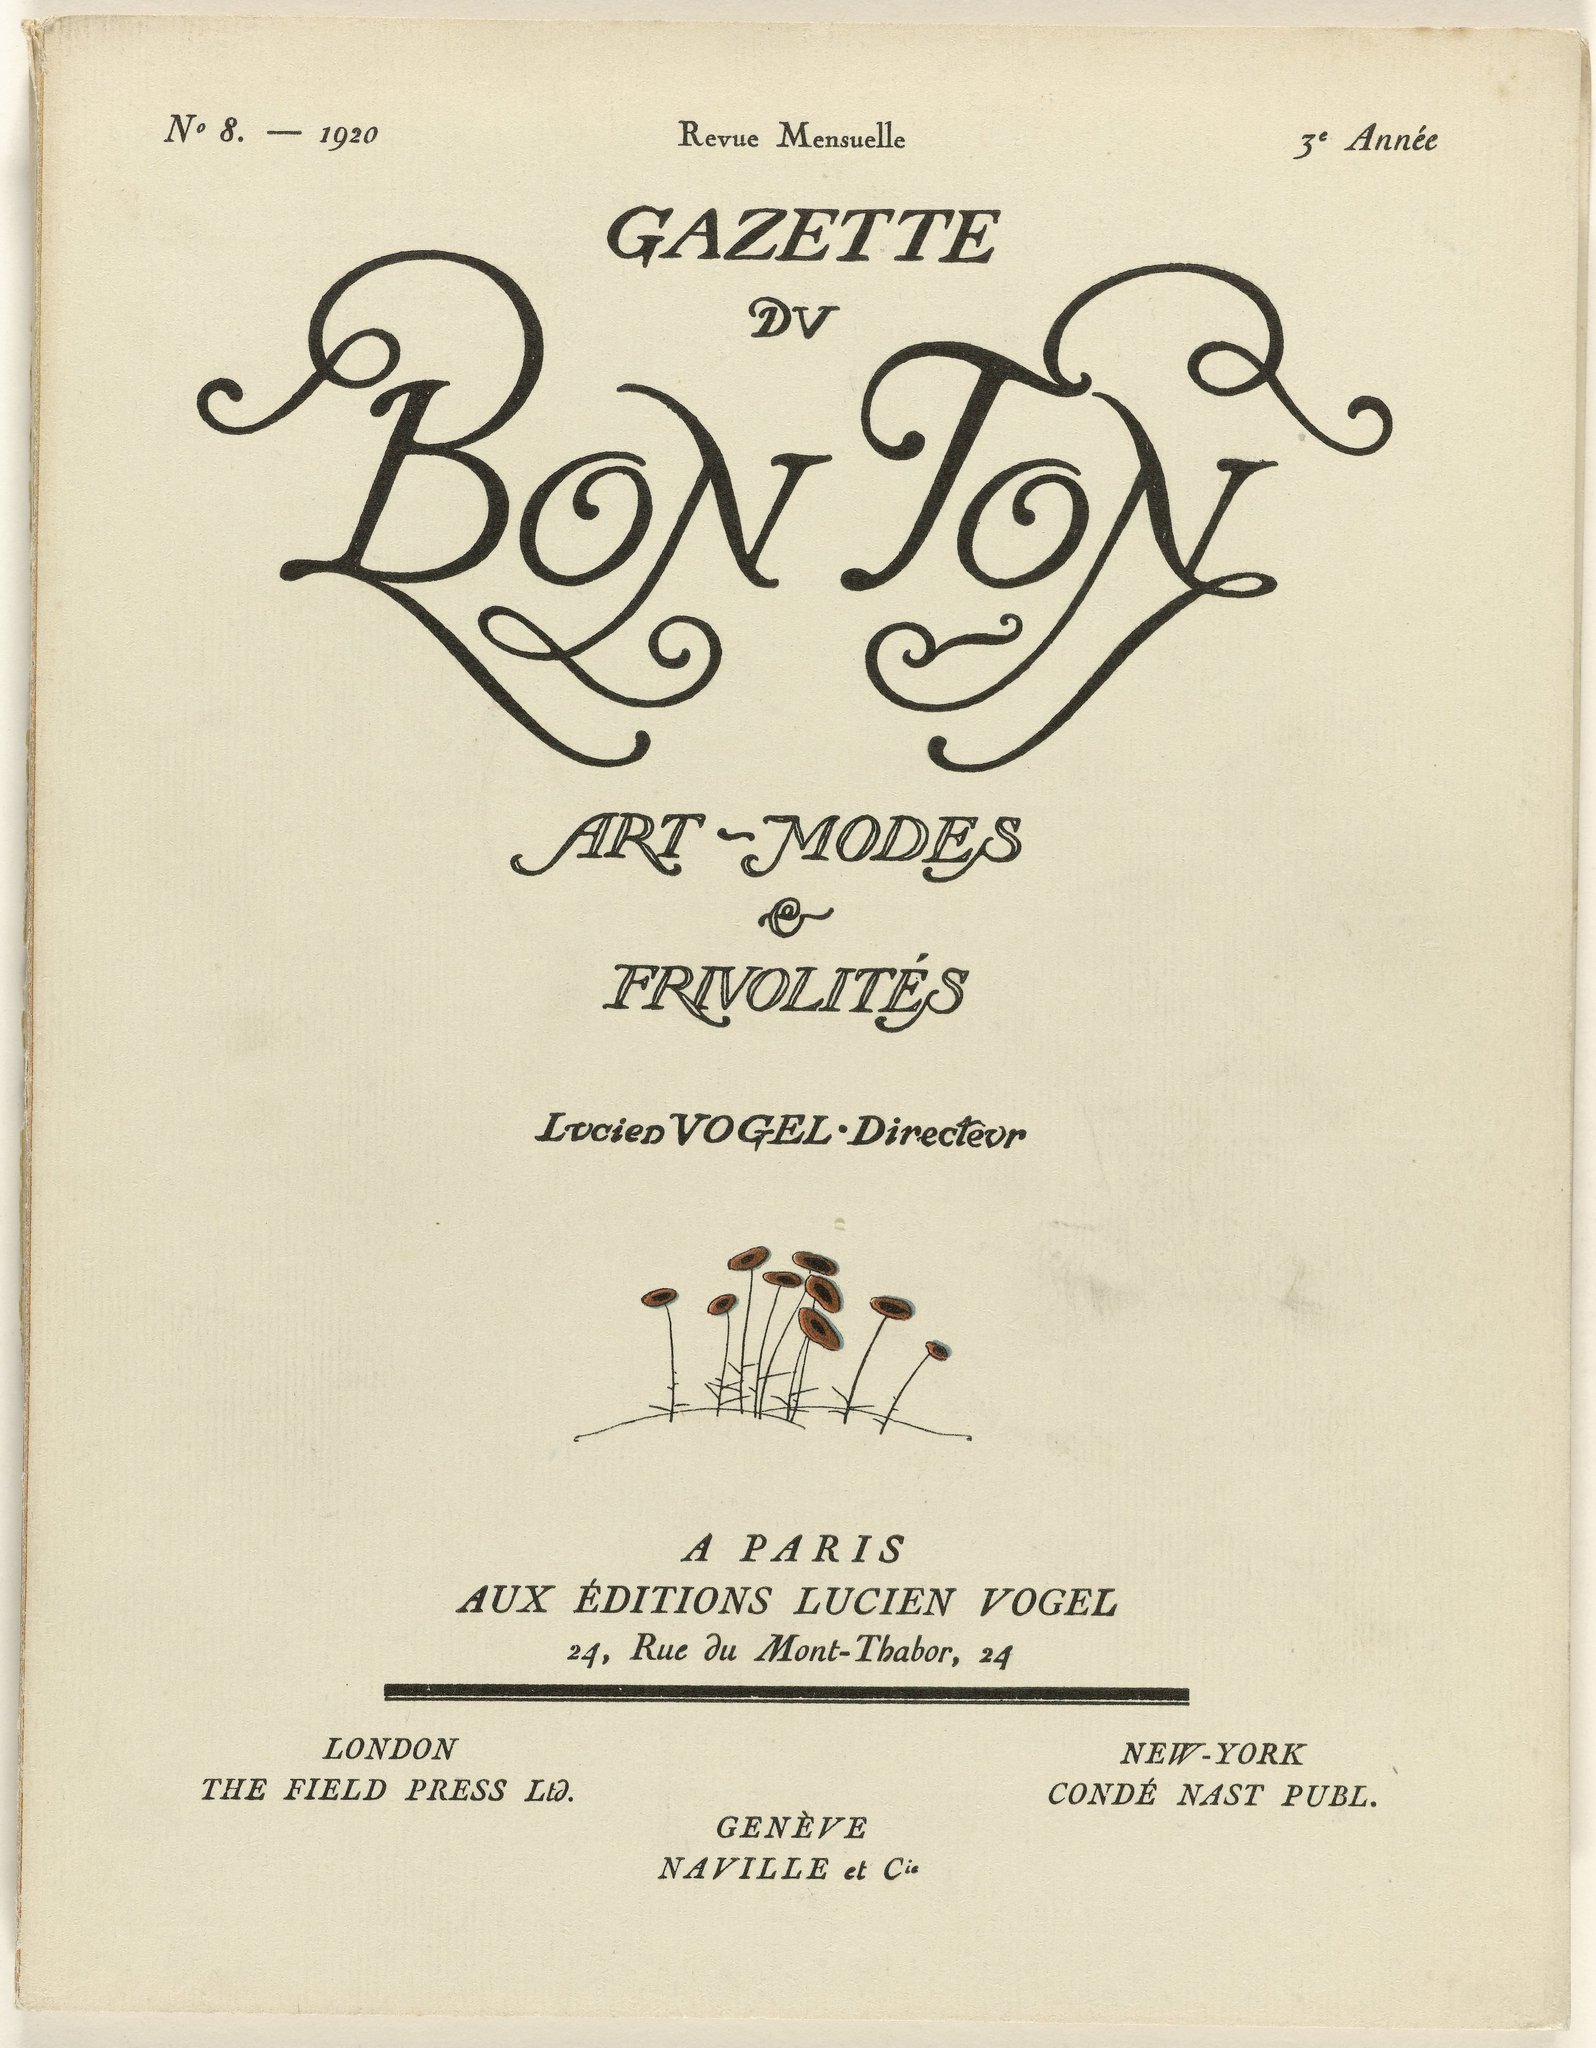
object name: magazine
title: Gazette du Bon Ton. Art - Modes & Frivolités, 1920, 3e Année, No.8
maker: lucien vogel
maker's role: publisher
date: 1920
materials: paper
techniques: letterpress printing, pochoir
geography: new york city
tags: fashion plates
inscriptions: date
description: Aflevering No. 8, september 1920, van Gazette du Bon Ton, bestaand uit een omslag, twaalf katernen met tekst en illustraties en twaalf losse prenten. Aan dit deel werkten de volgende modeontwerpers mee: Beer, Cheruit, Doeuillet, Doucet, Lanvin, Paquin, Paul Poiret, Redfern en Worth.